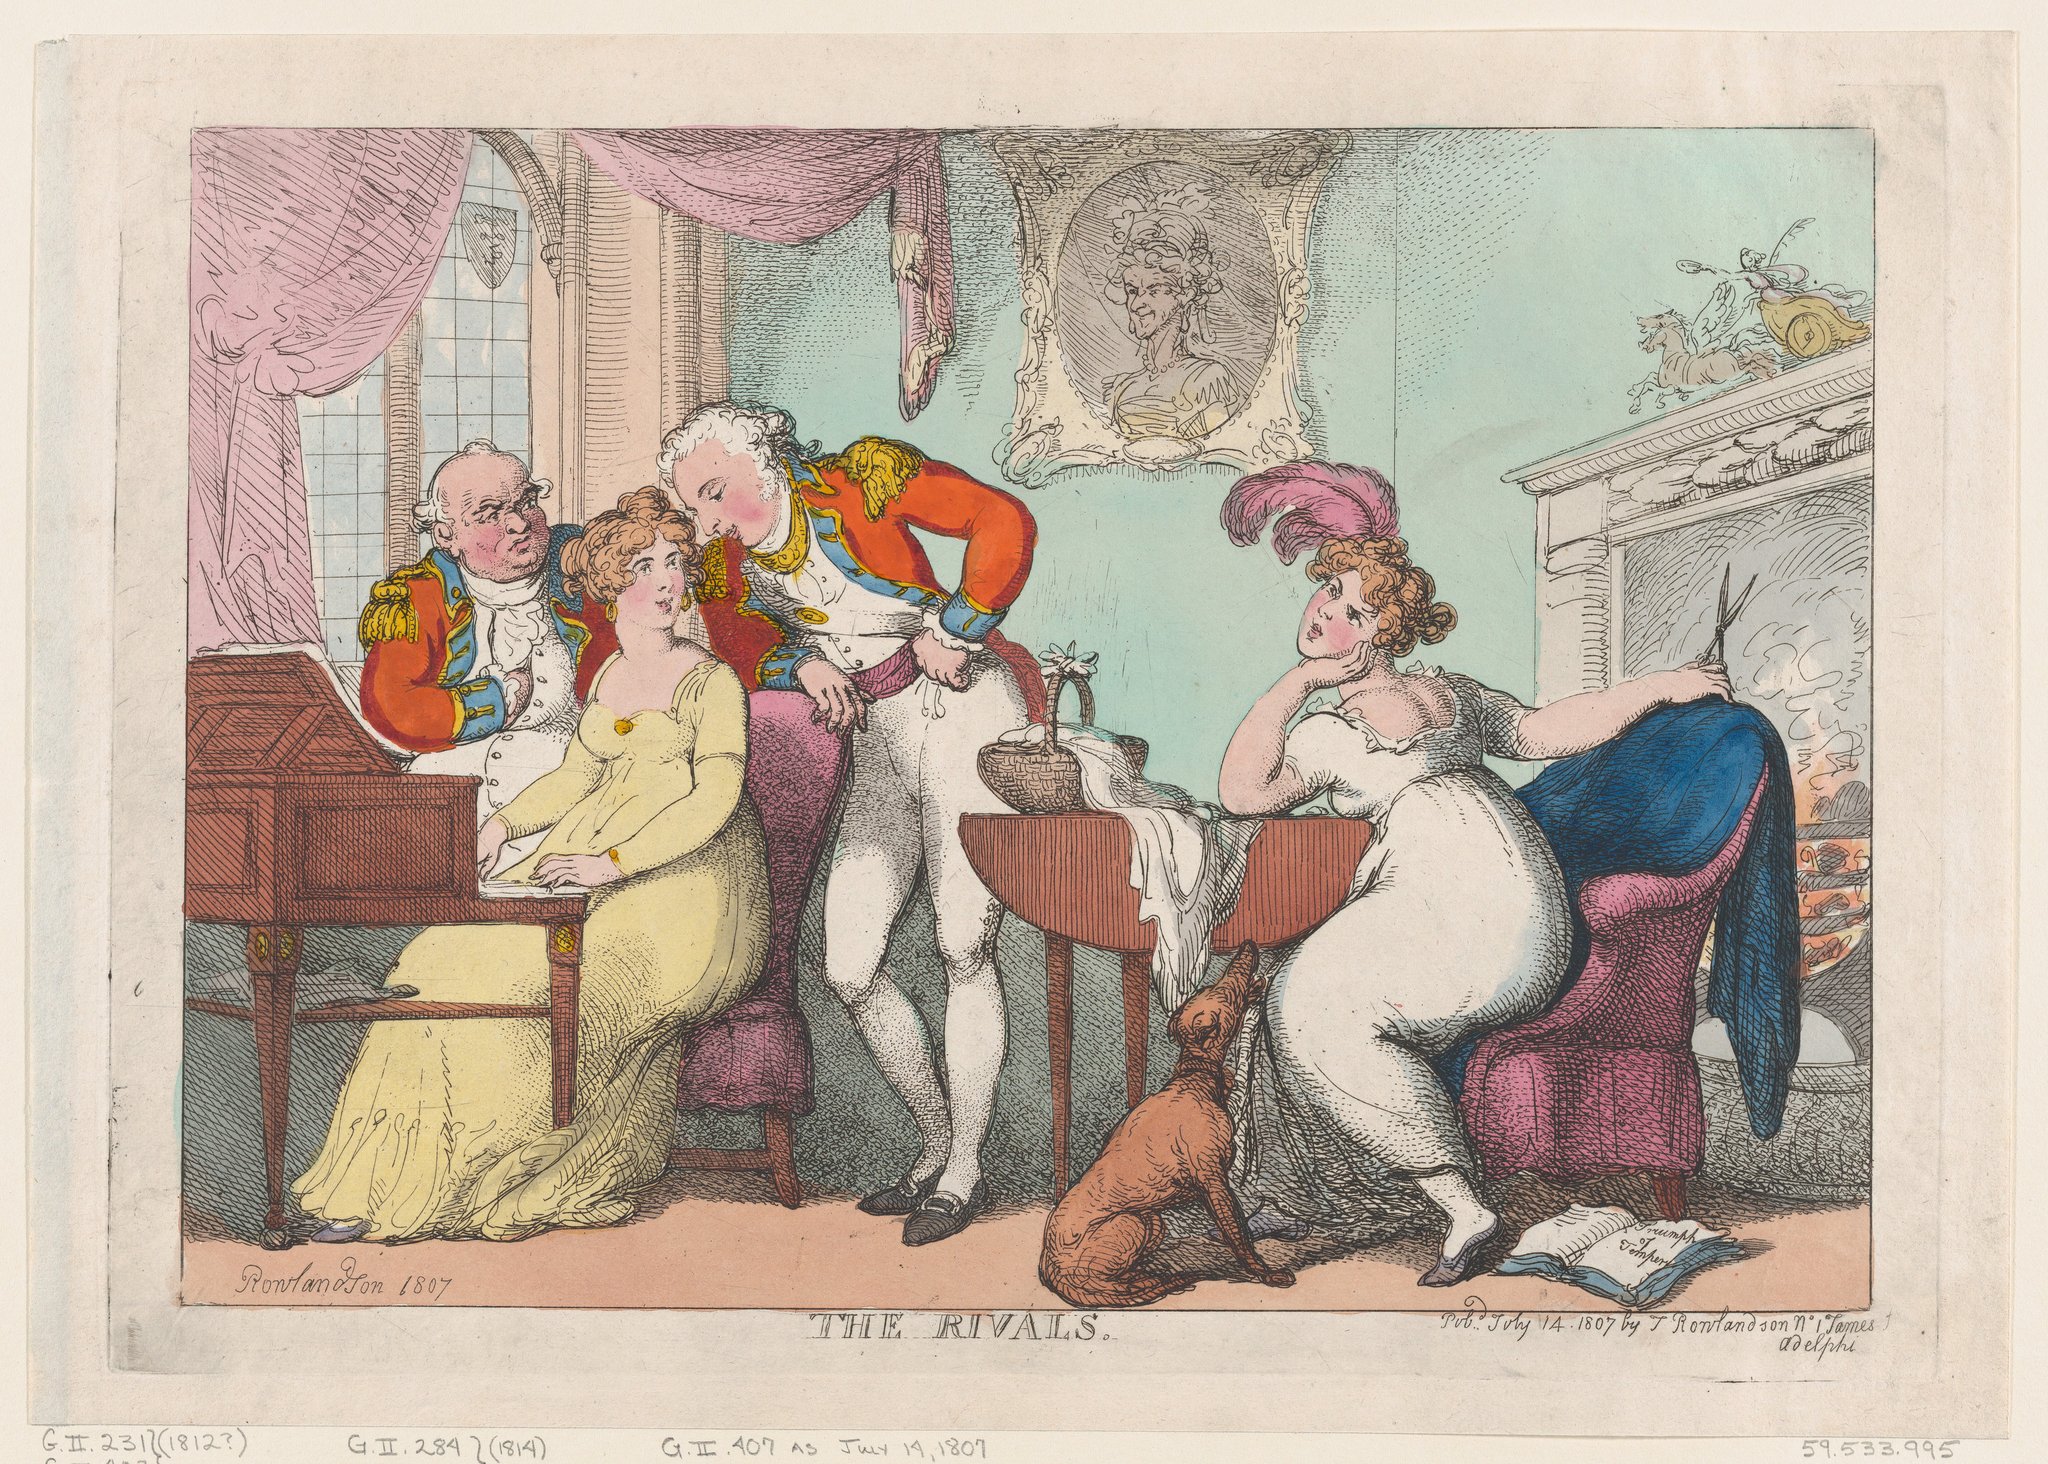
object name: print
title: The Rivals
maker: thomas rowlandson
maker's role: artist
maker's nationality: british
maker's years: 1757-1827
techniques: etching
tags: men,women,pianos,dogs